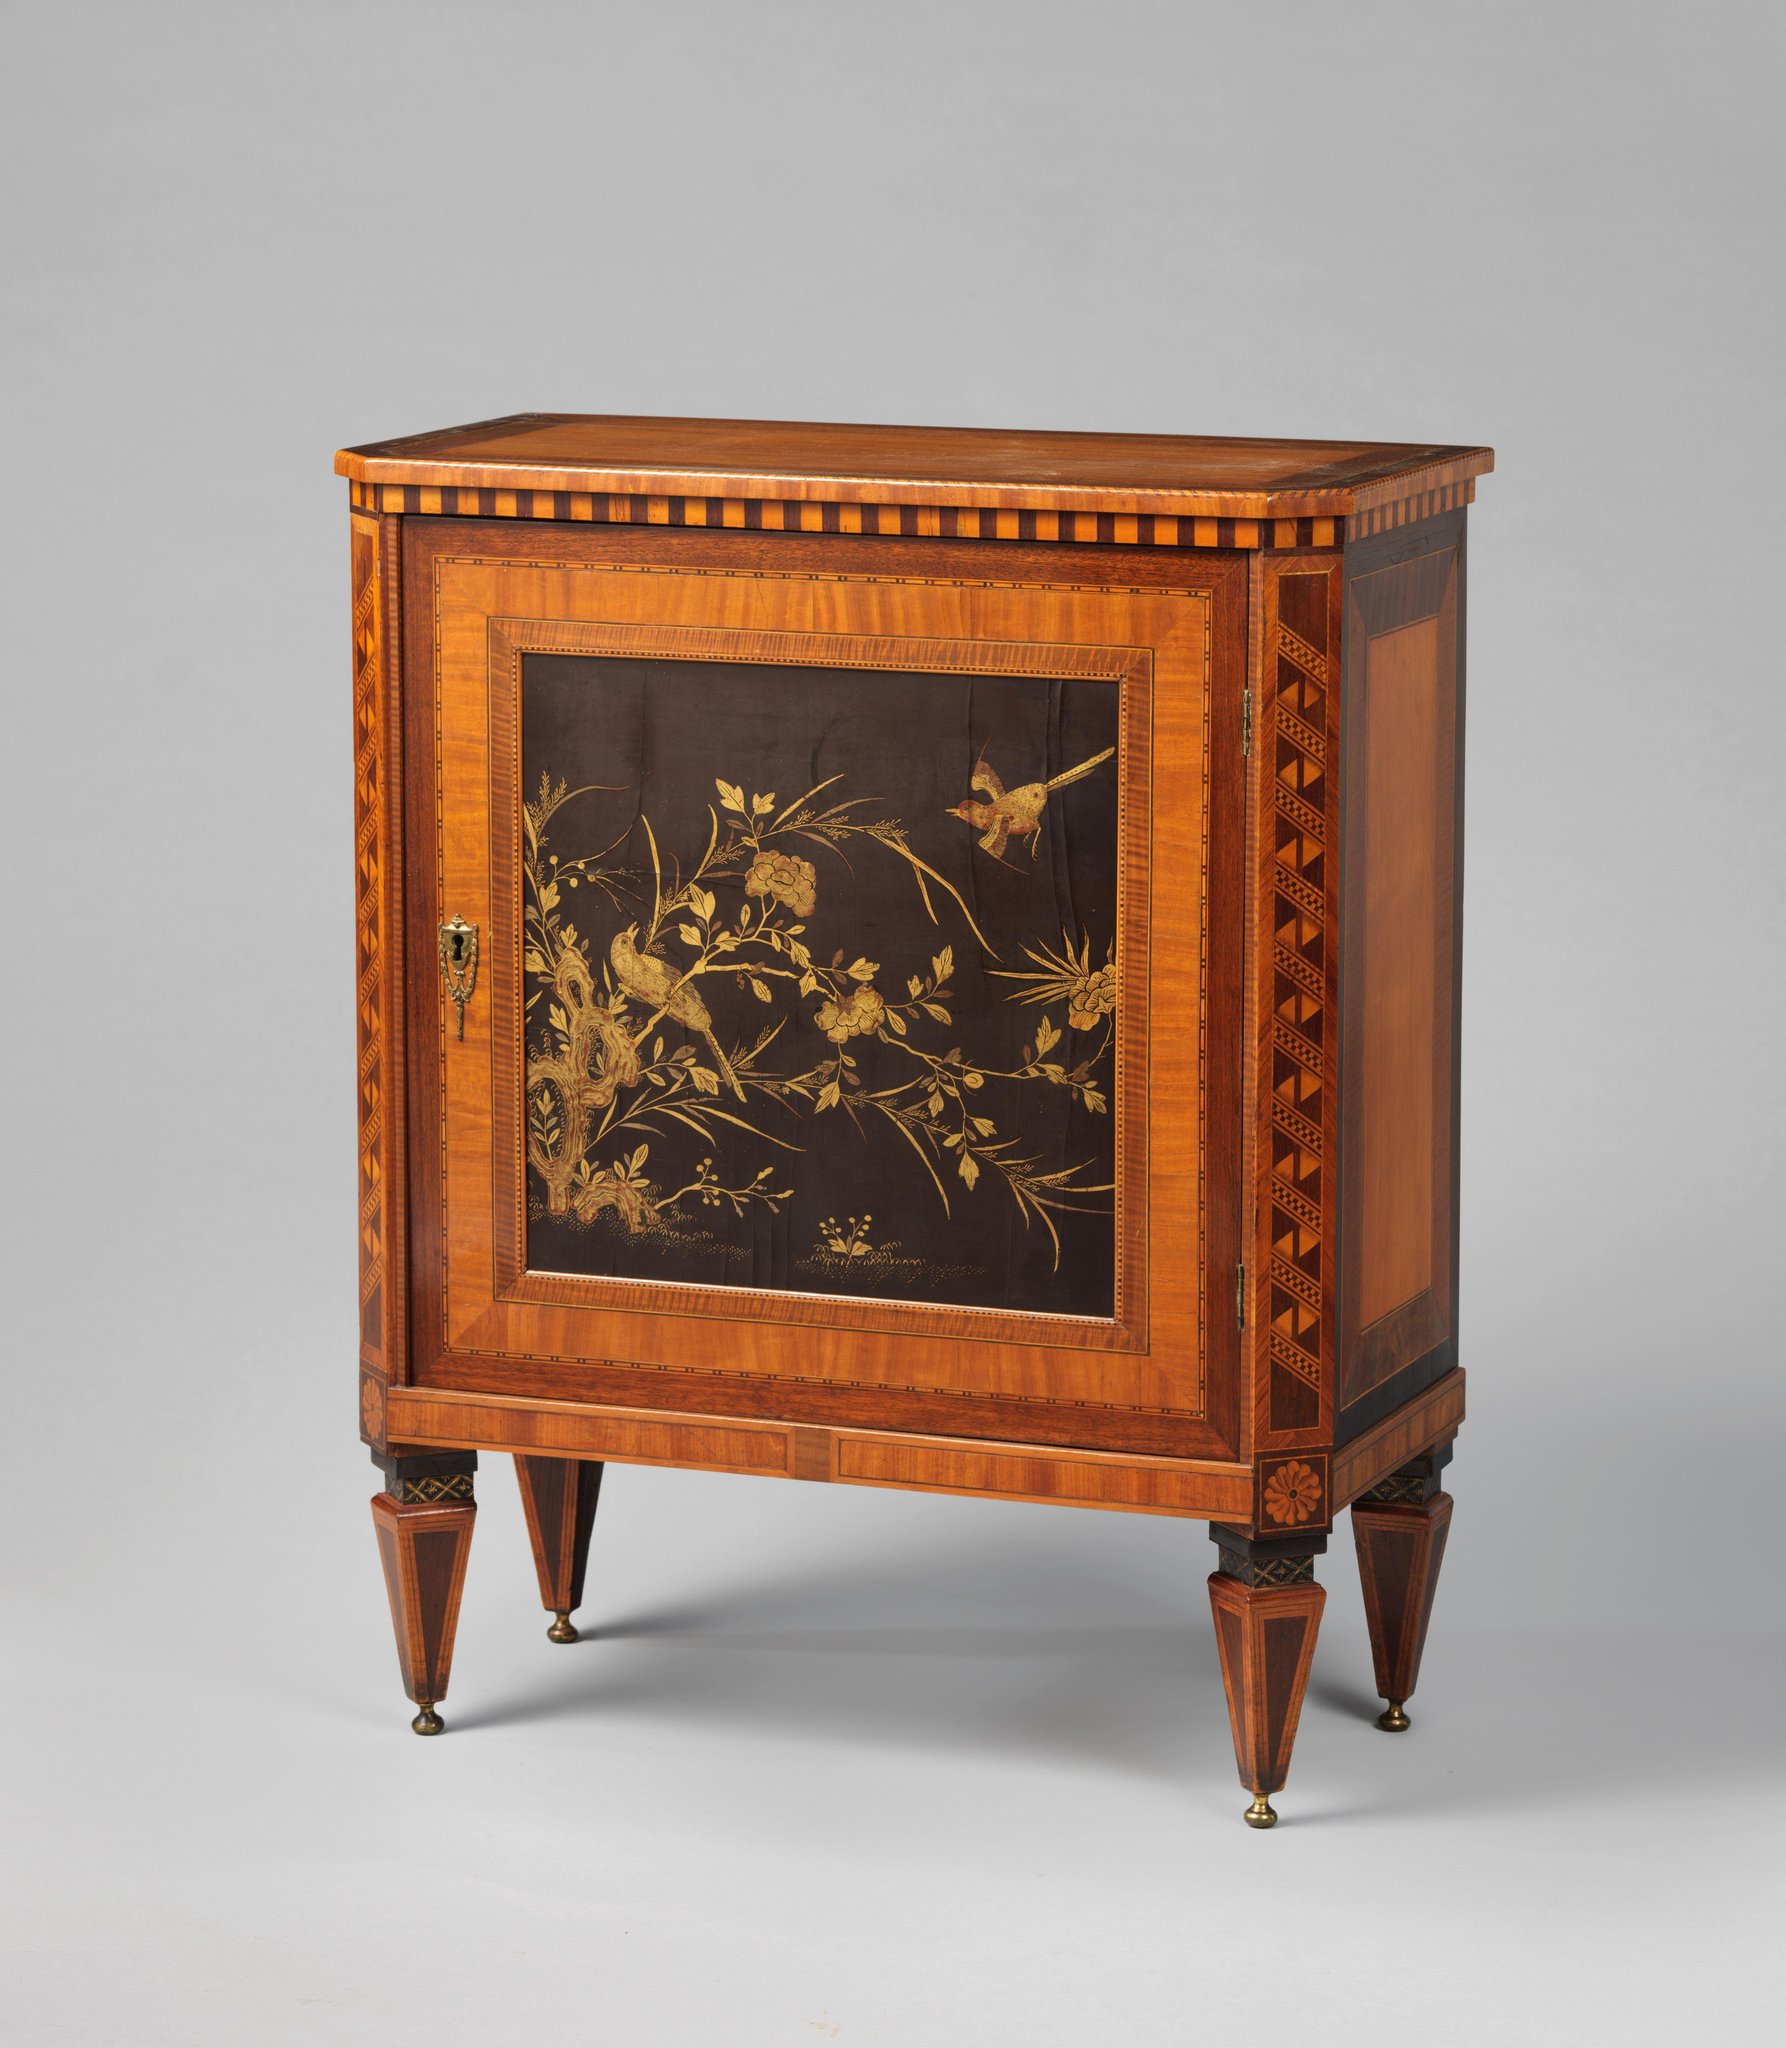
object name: furniture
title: Kast met deur met lakpaneel, goudlak op zwarte grond, met vogels, bloemen en planten.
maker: Anonymous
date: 1780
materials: lacquer, wood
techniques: lacquer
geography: northern netherlands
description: Cupboard, oak, veneered with various woods, inlaid with a Dutch lacquer panel. Netherlands, c. 1780 - 1795. Given by Mr and Mrs De Bruijn-van der Leeuw, 1961.